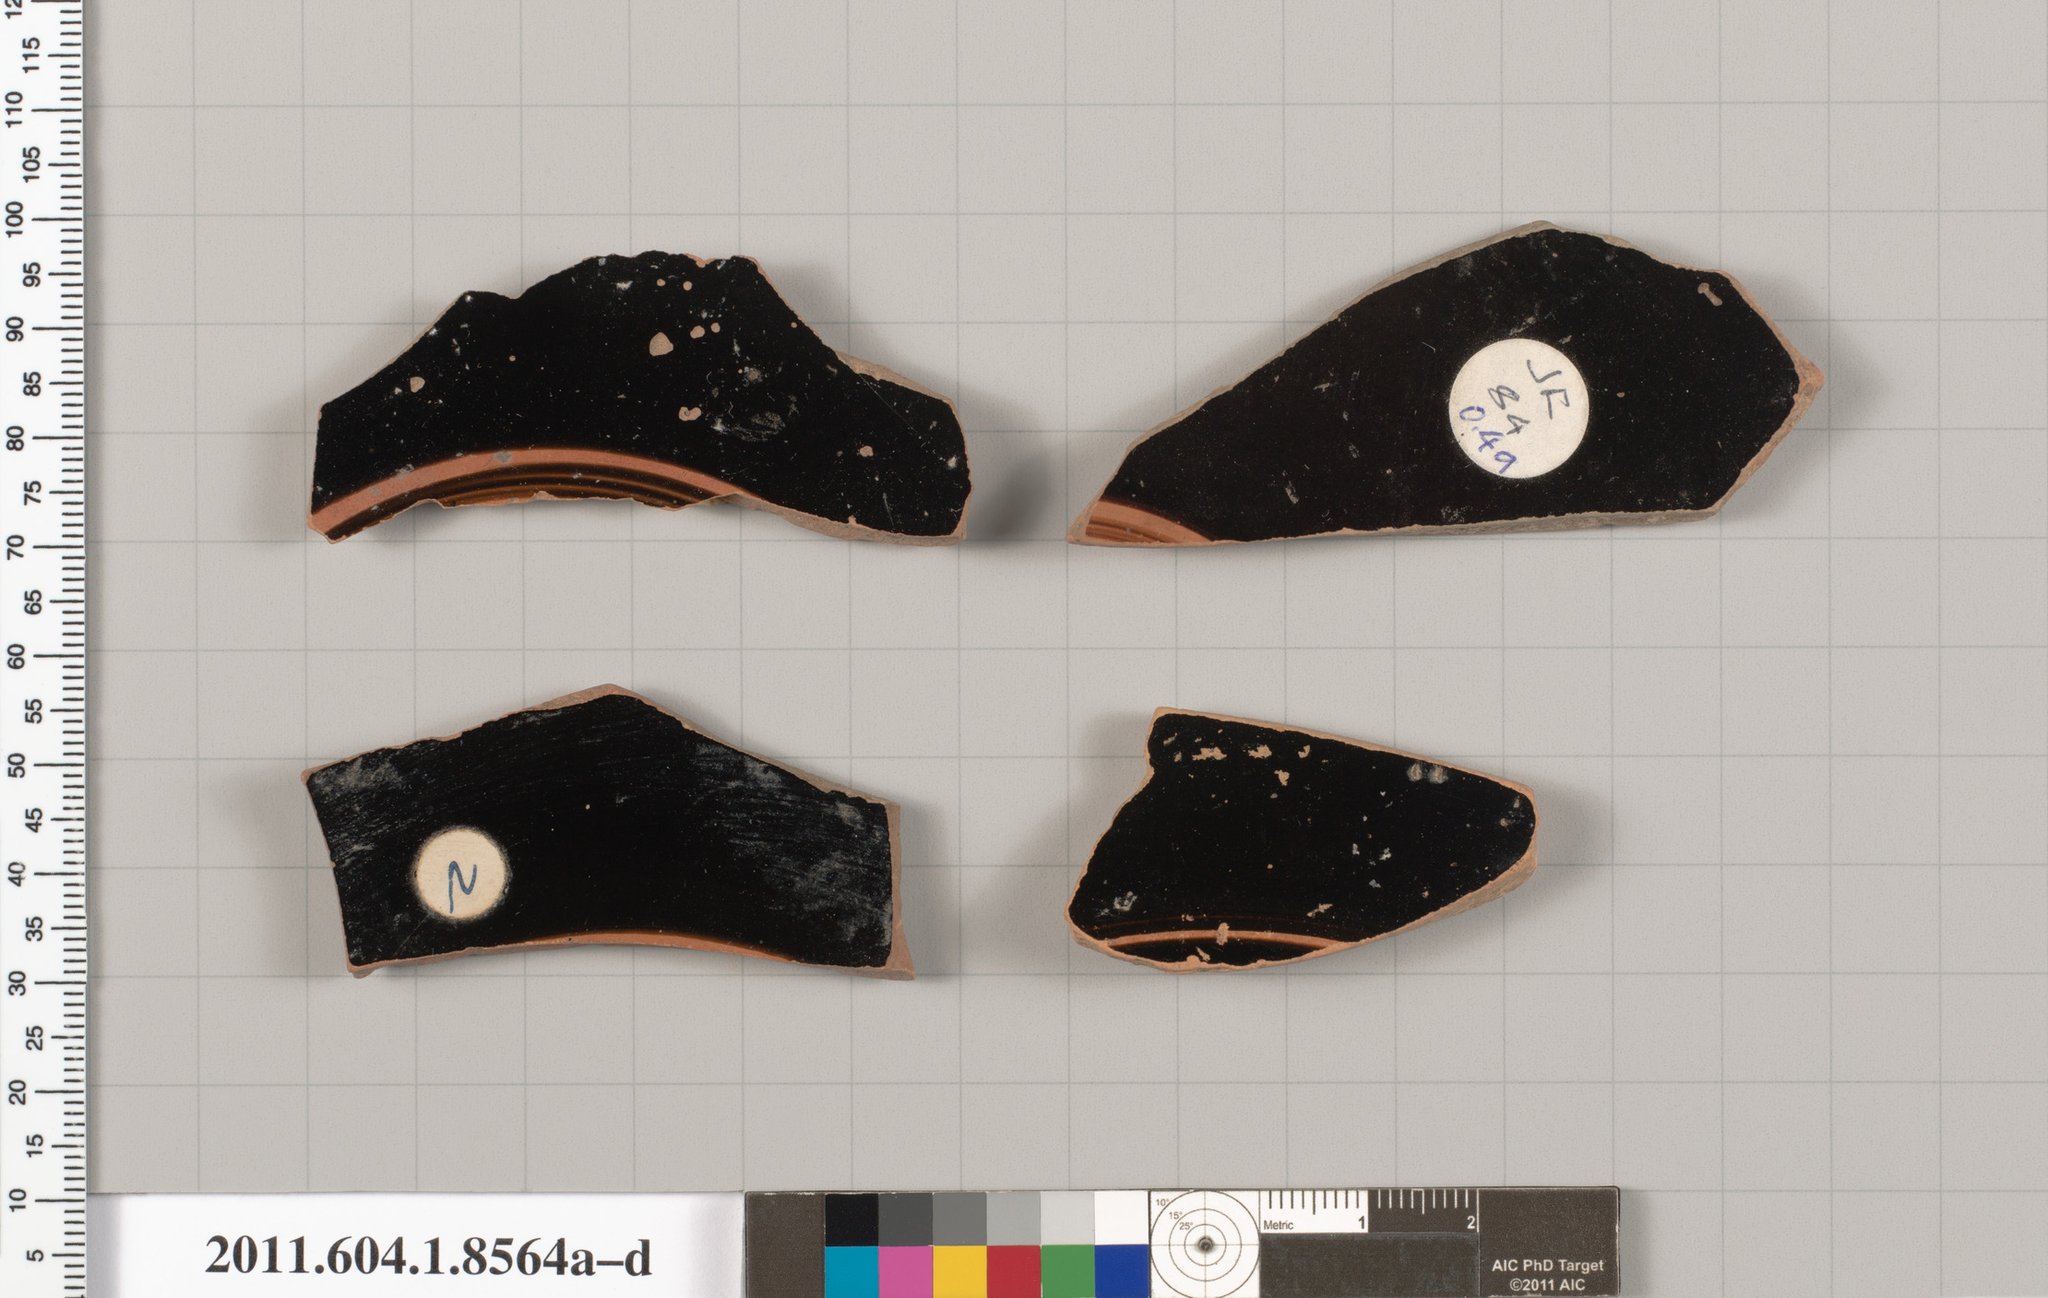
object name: kylix fragment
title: Terracotta fragments of stemless kylikes (drinking cups)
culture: greek, attic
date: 470-450 BCE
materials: terracotta